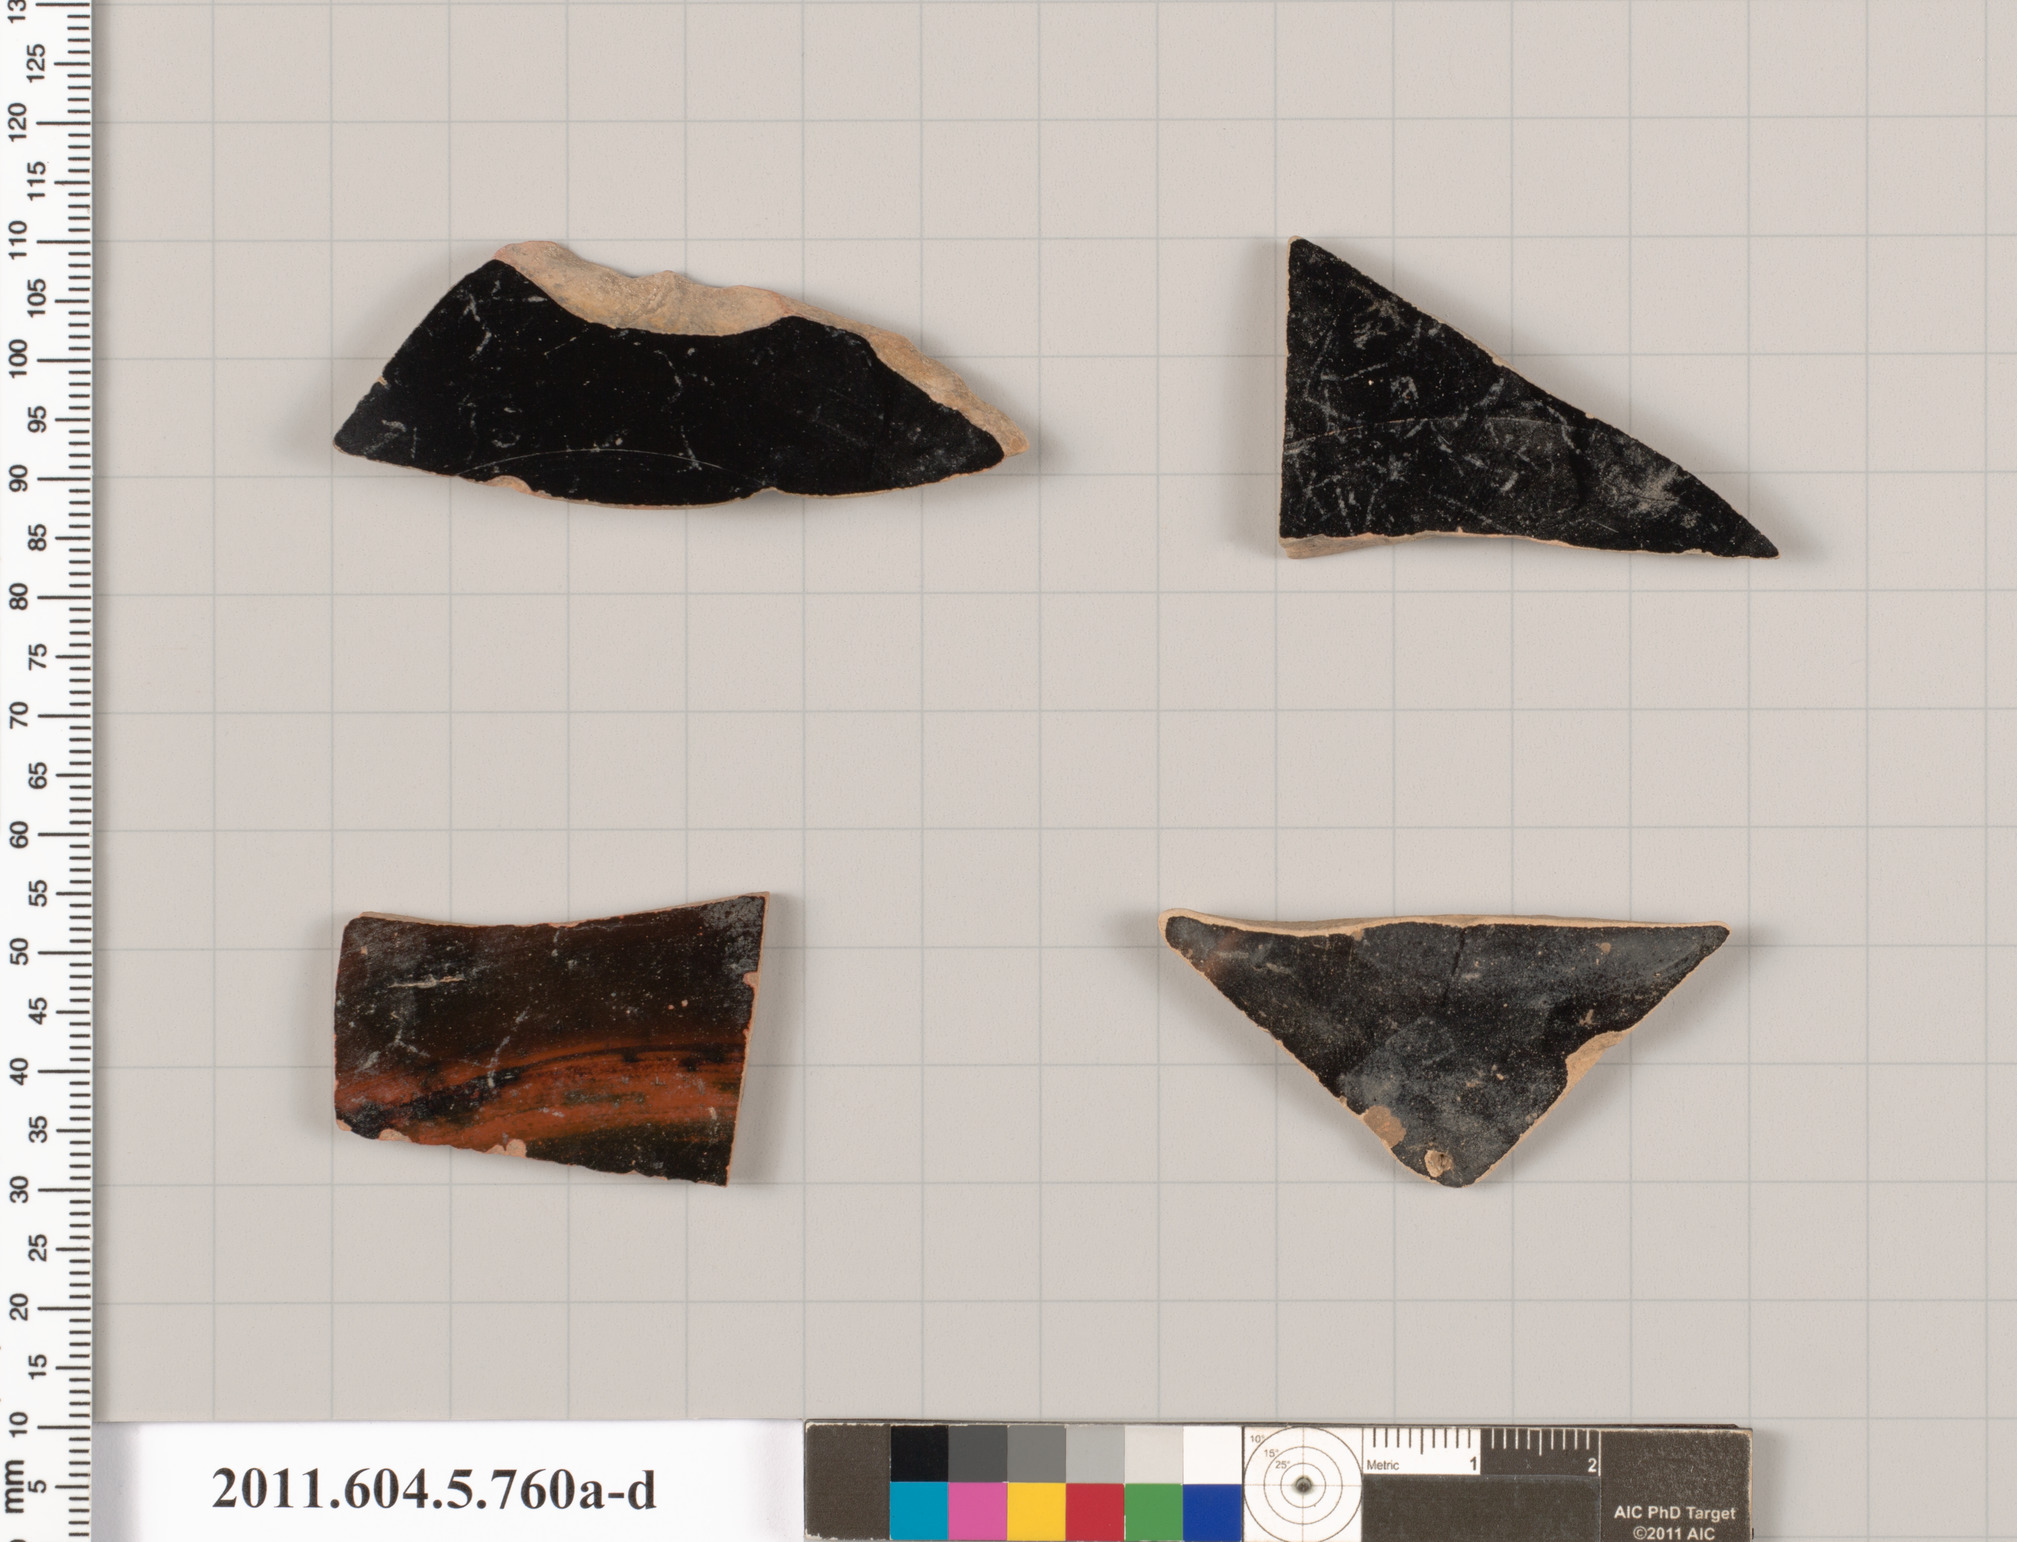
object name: kylix fragment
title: Terracotta fragments of kylikes (drinking cups)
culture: greek, attic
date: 600-401 BCE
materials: terracotta